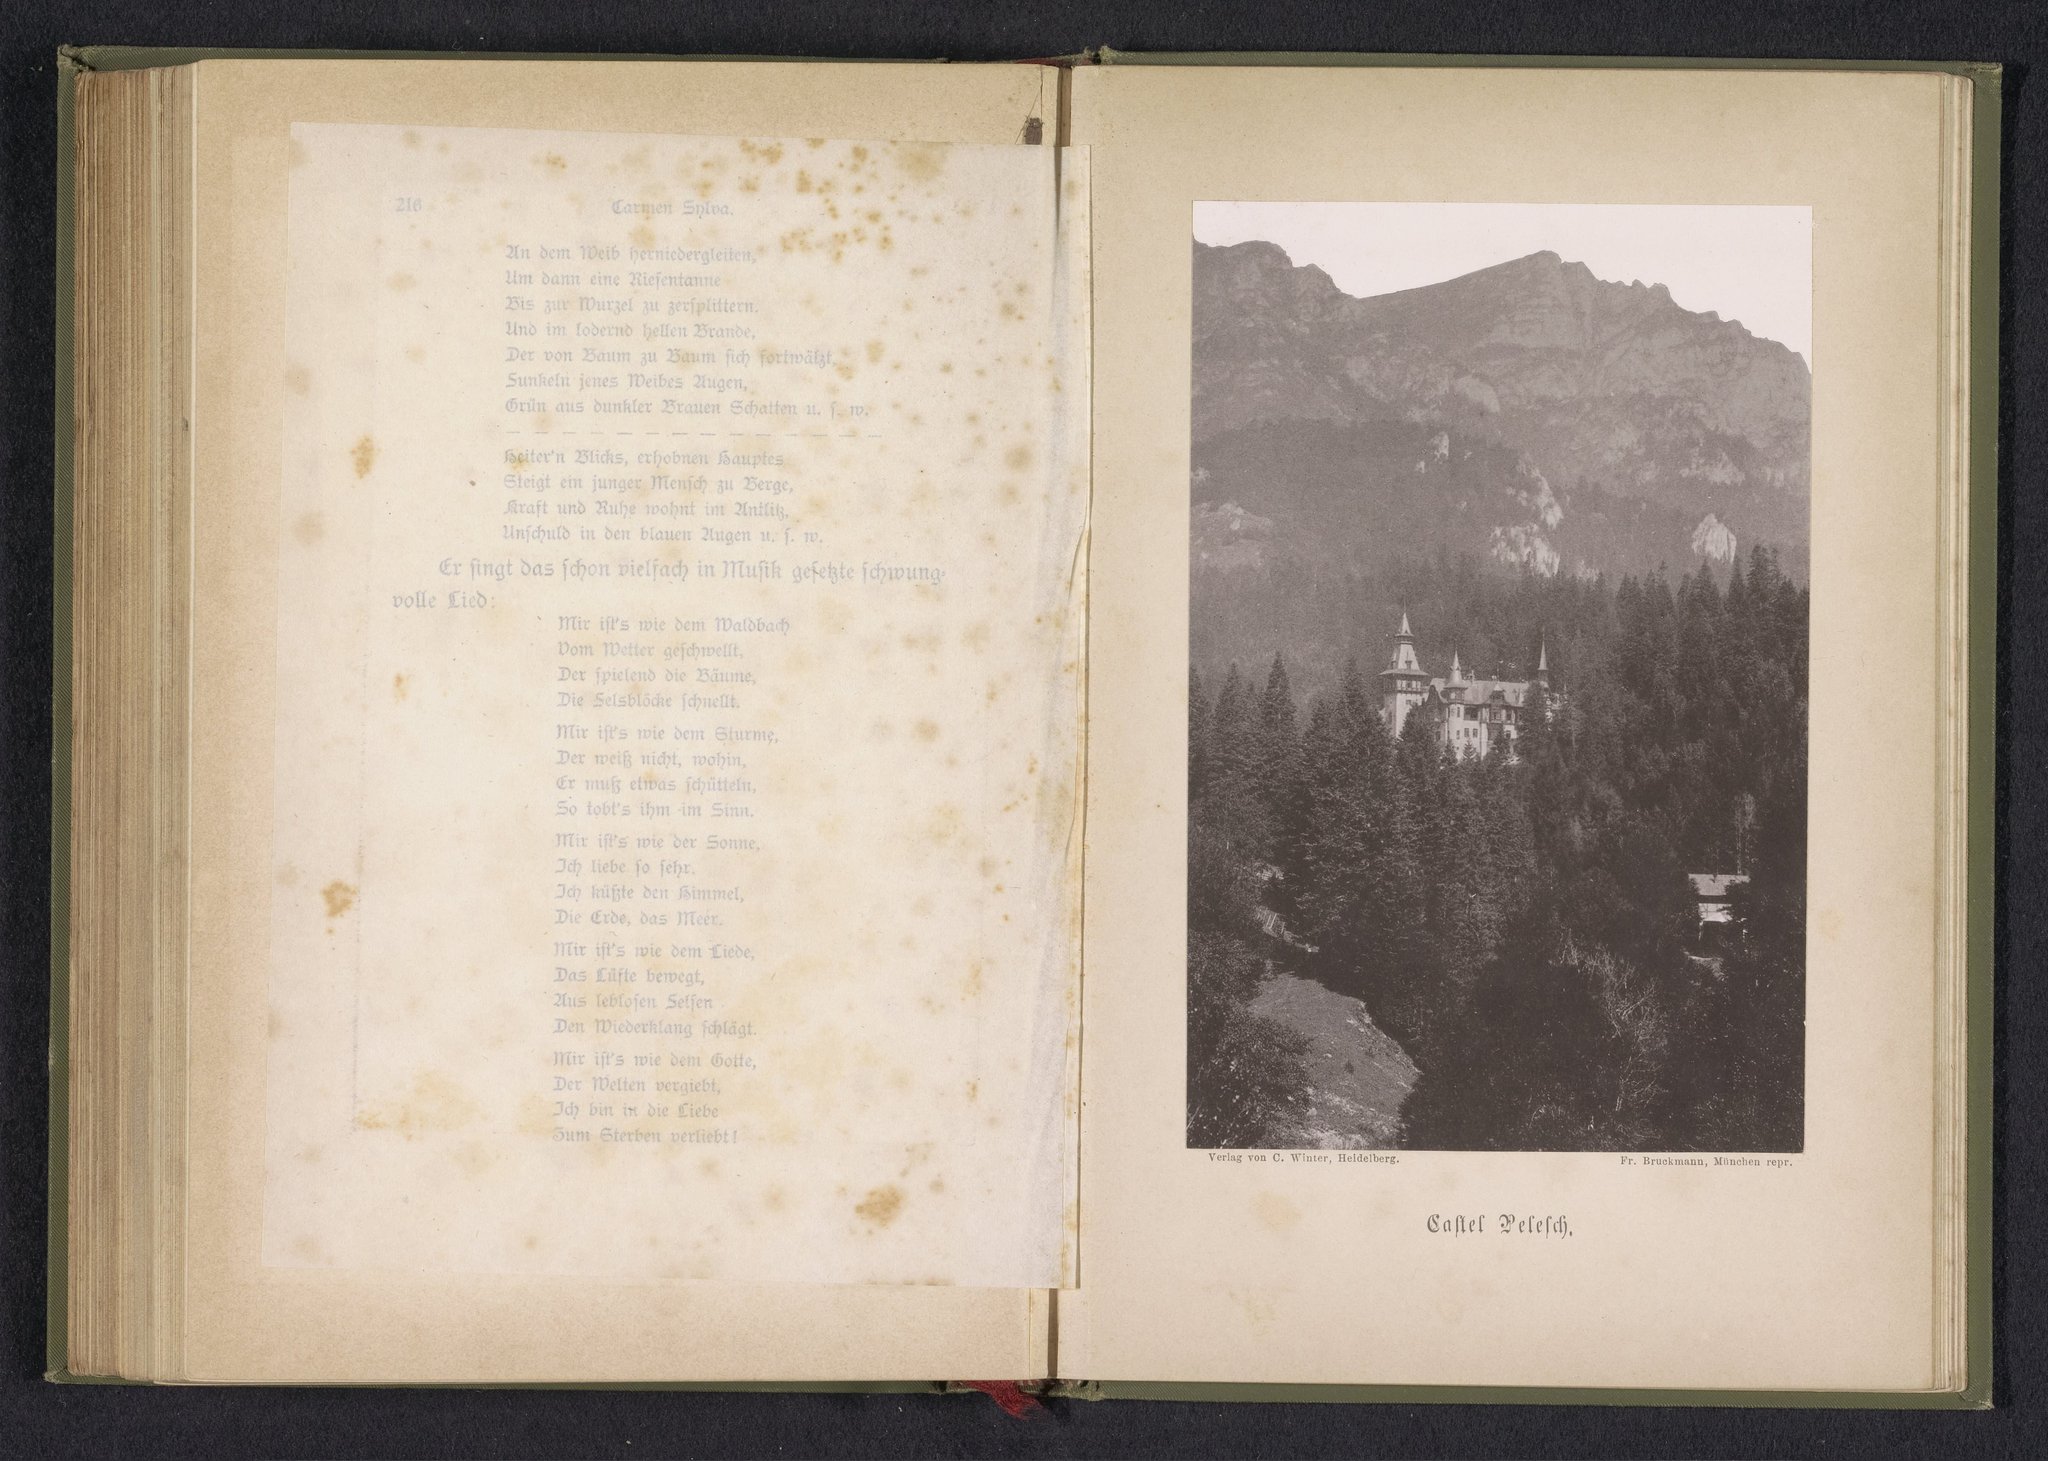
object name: photomechanical print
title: Castel Pelesch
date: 1876-1886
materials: paper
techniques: photograph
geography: heidelberg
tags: castle, façade (of house or building)